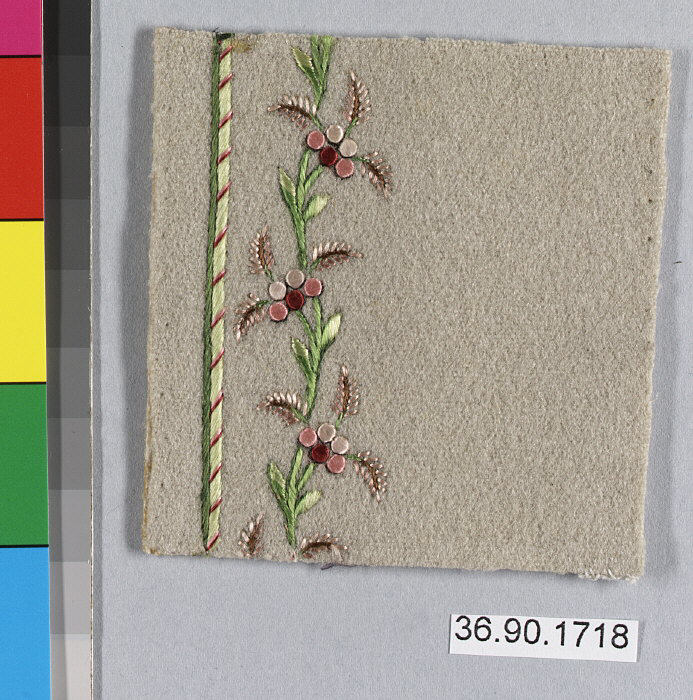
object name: sample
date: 1801-1833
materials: felt, silk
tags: flowers